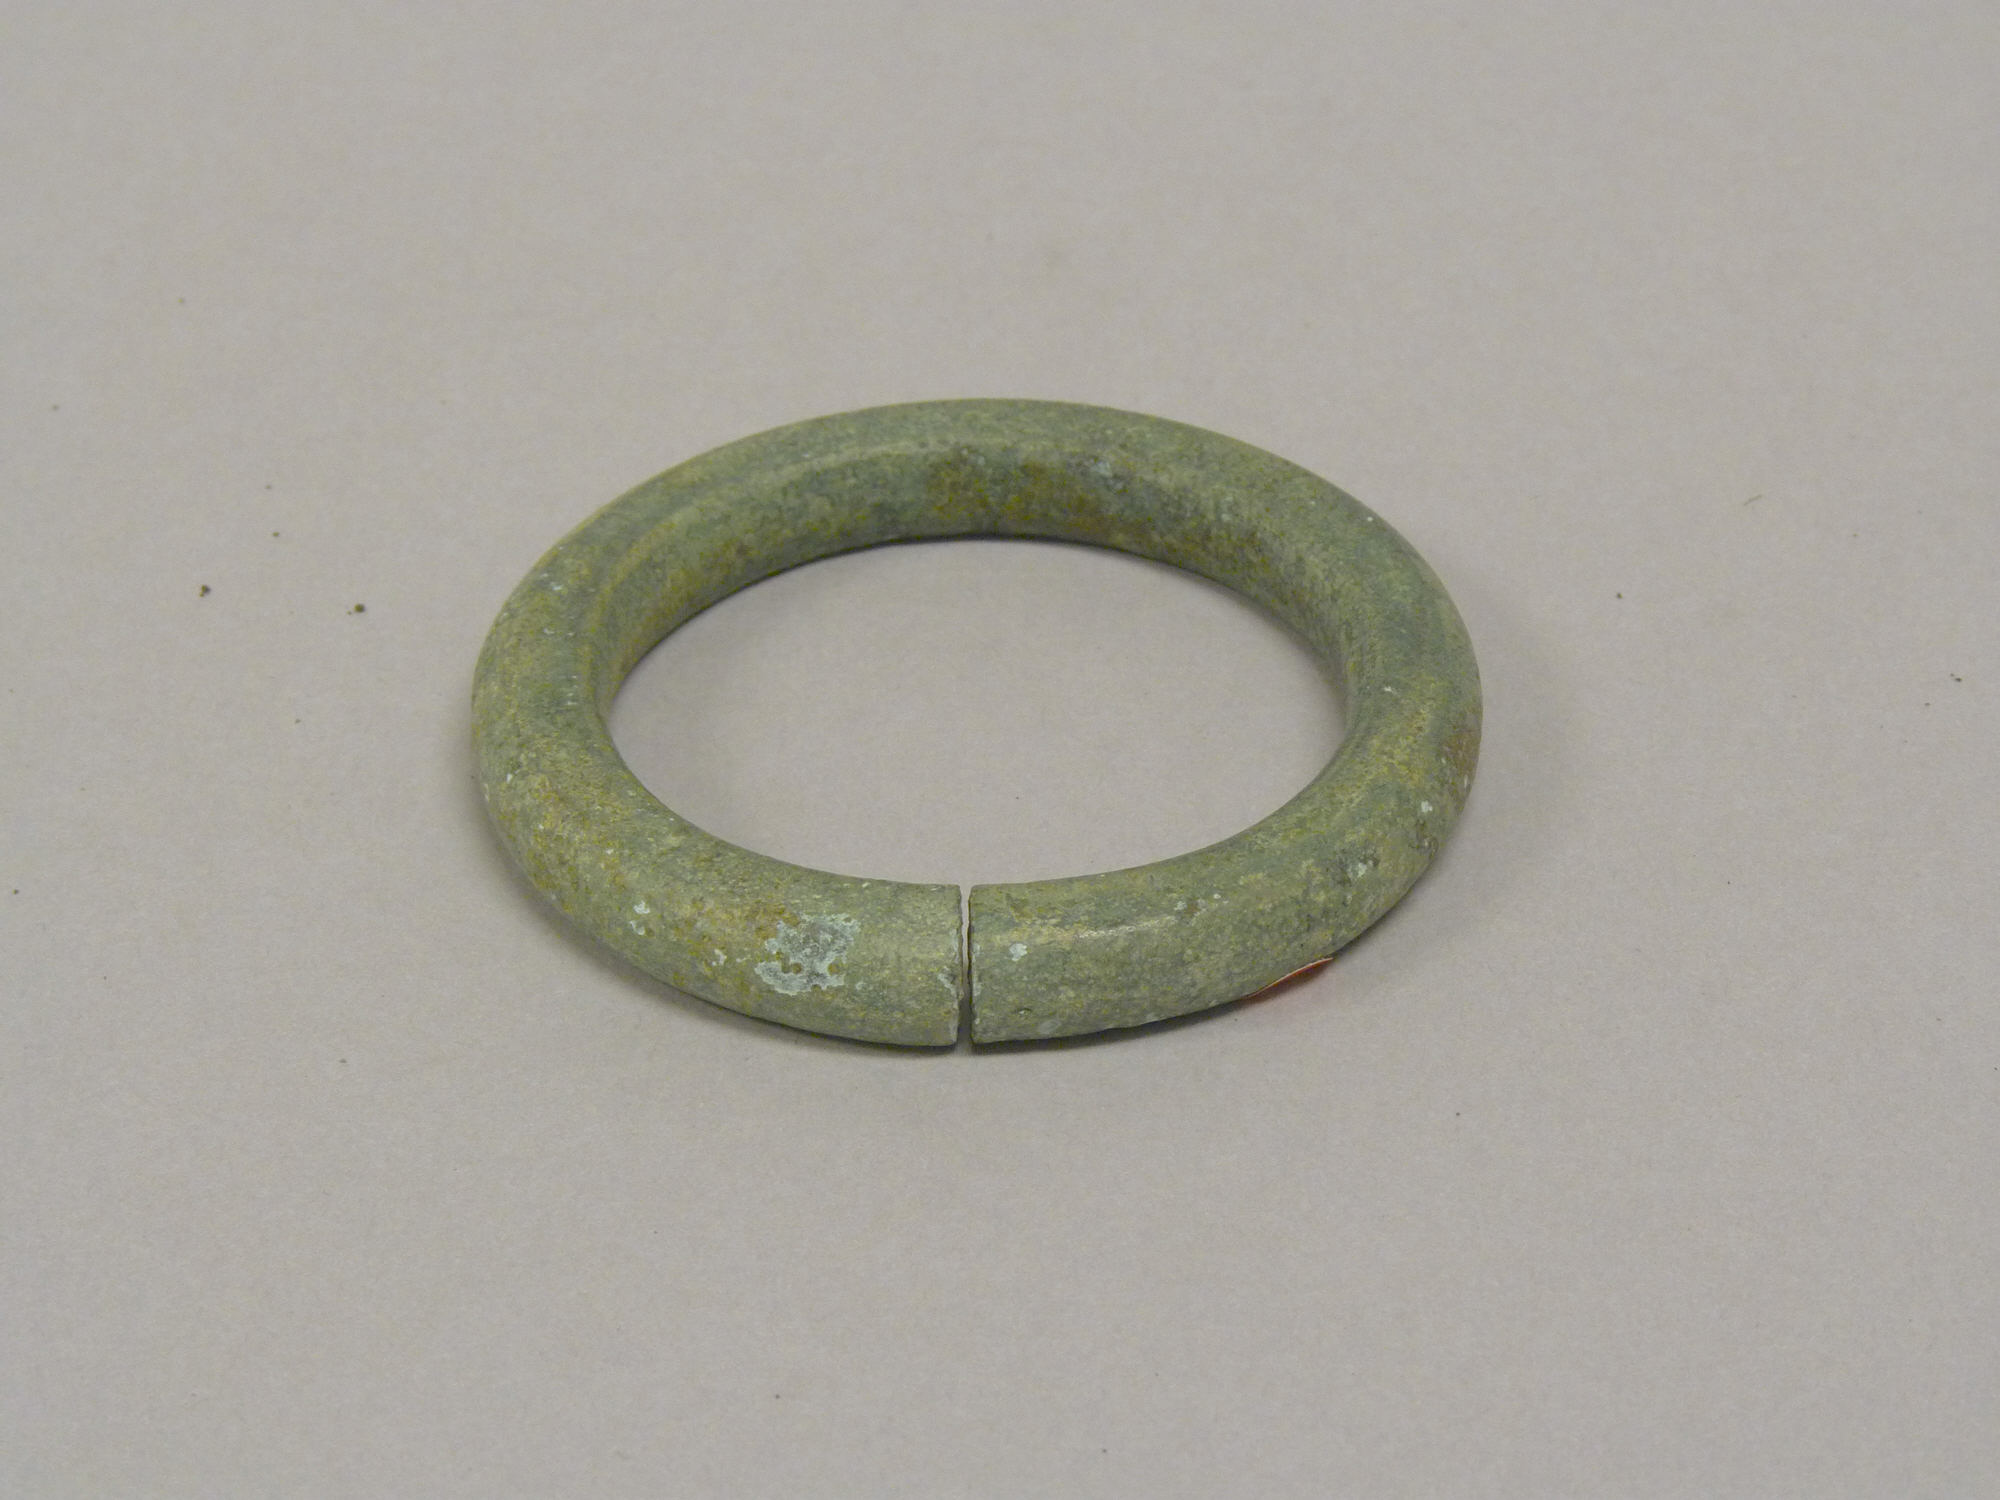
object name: bangle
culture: thai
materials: bronze